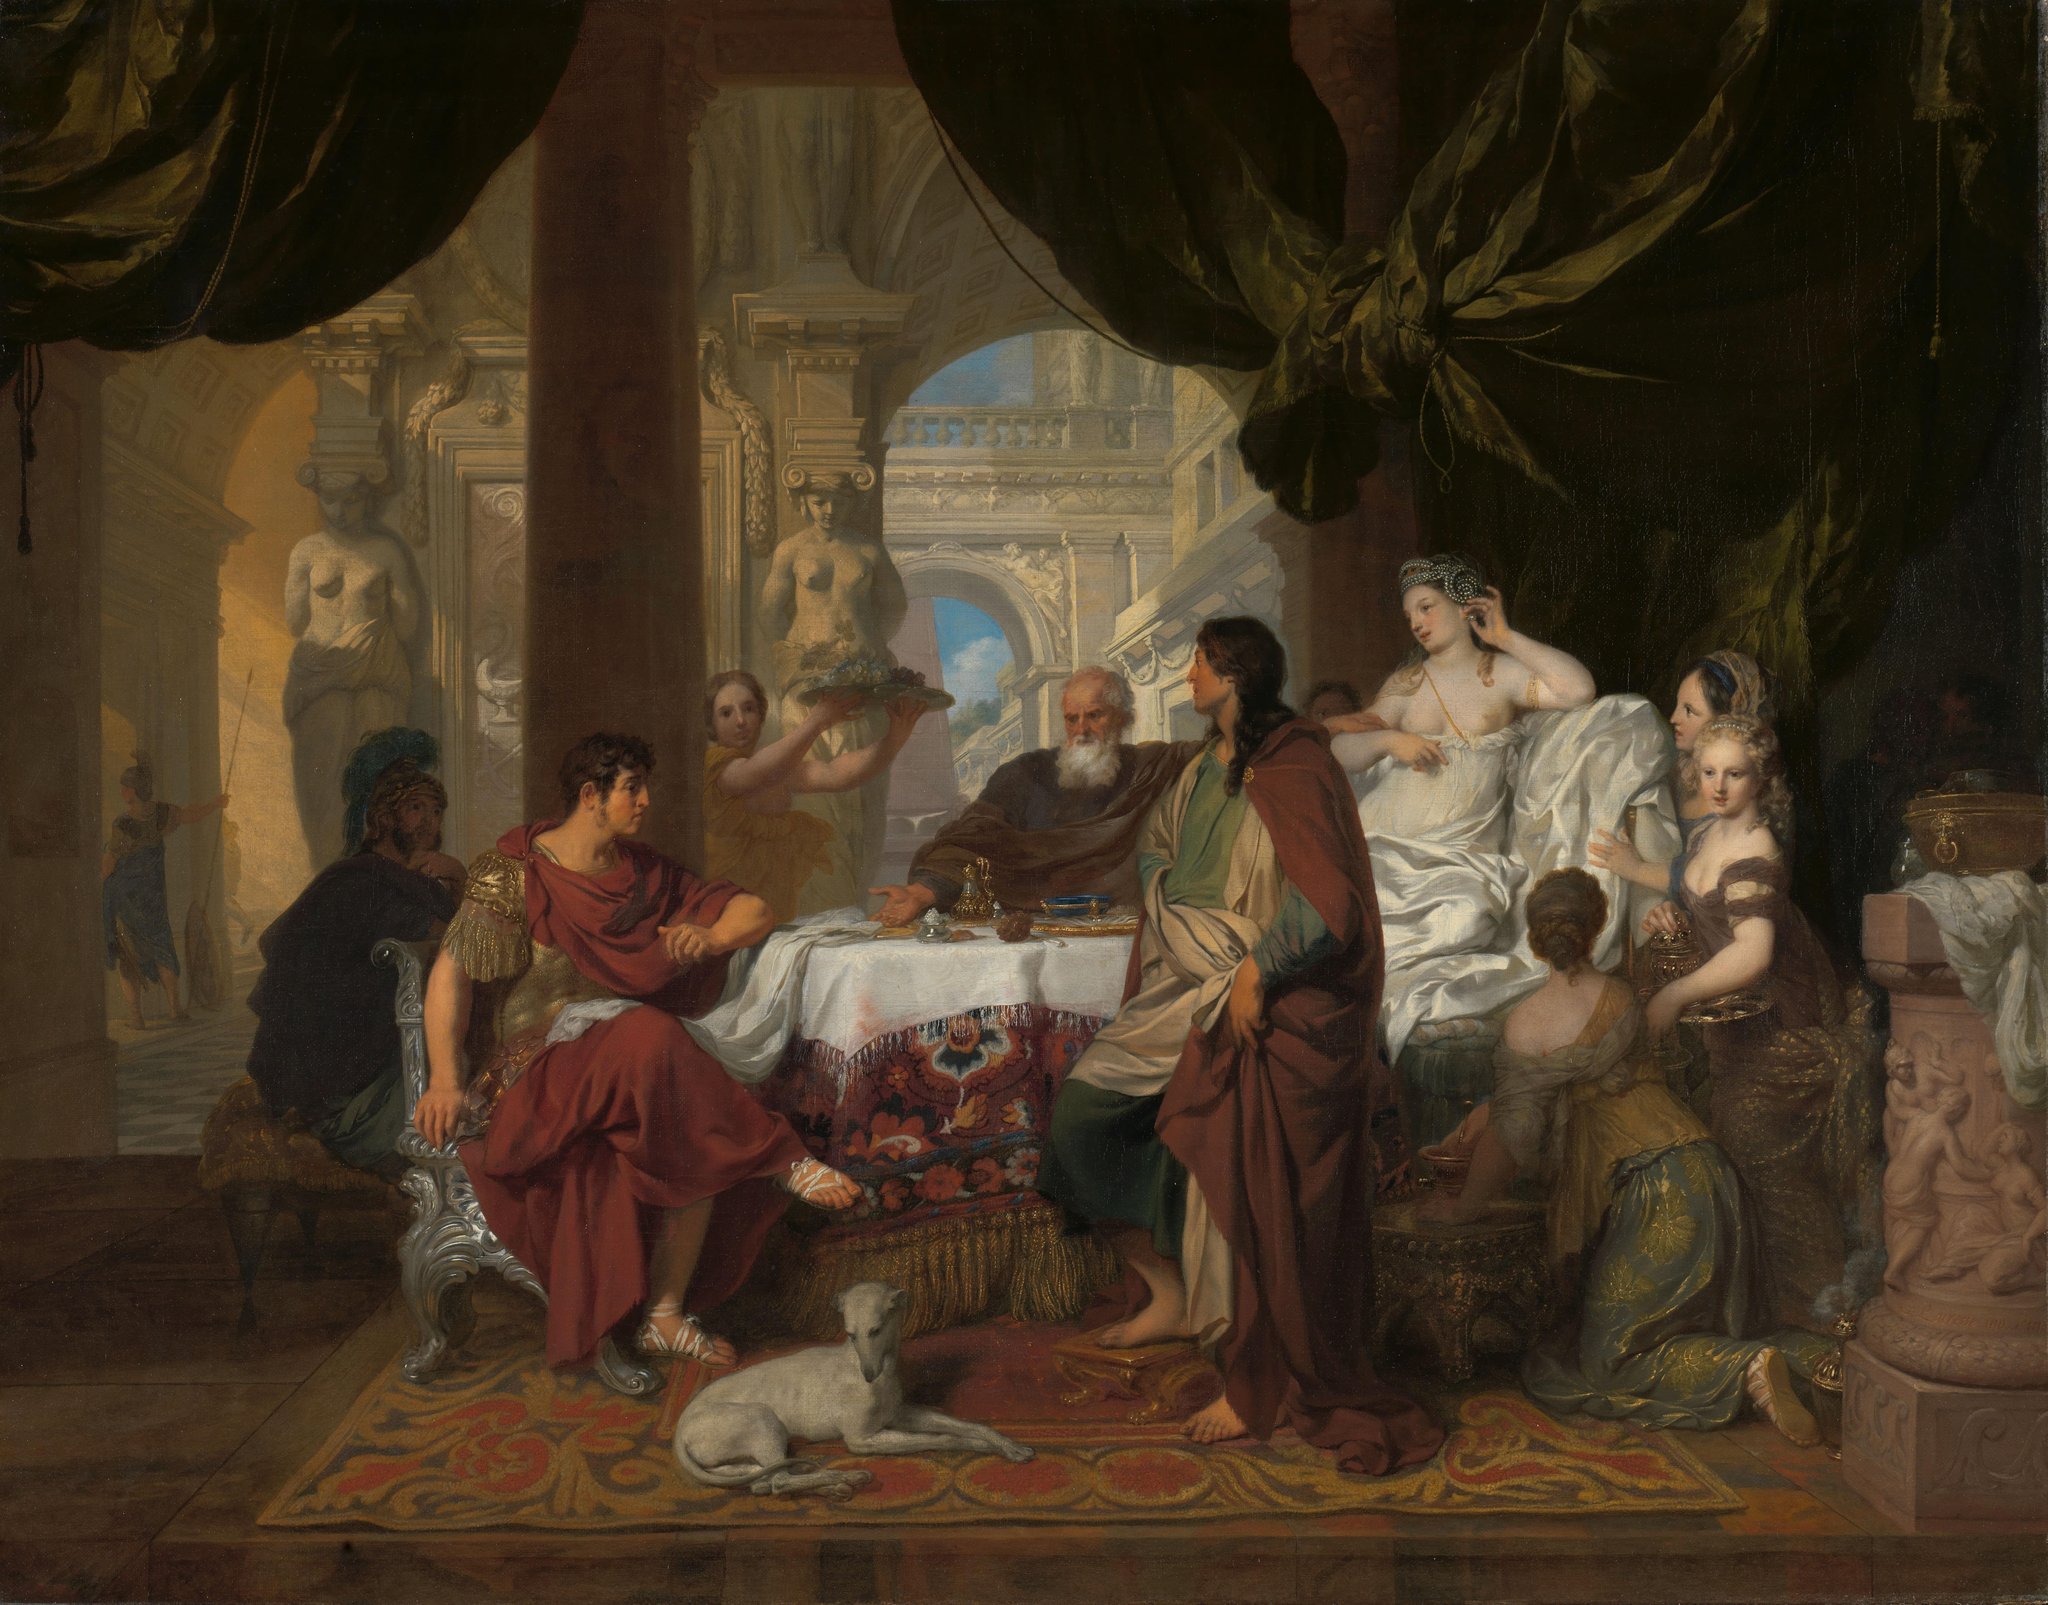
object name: painting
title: Cleopatra's Banquet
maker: gerard de lairesse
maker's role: draughtsman, painter, print maker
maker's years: 1641-1711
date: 1675-1680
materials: canvas, oil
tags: banquet of mark antony and cleopatra: she dissolves a pearl in a cup of wine, which she then drinks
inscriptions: signature: ‘G. Lairesse inv Pinx.’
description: Who could throw the most lavish banquet? This was the bet between the Egyptian pharaoh Cleopatra and the Roman general Mark Antony. Cleopatra won the wager by dissolving a pearl in vinegar and then drinking the mixture. In this painting, she is just removing her earring. De Lairesse painted this story like a scene from a play, with antique costumes and classical architecture.